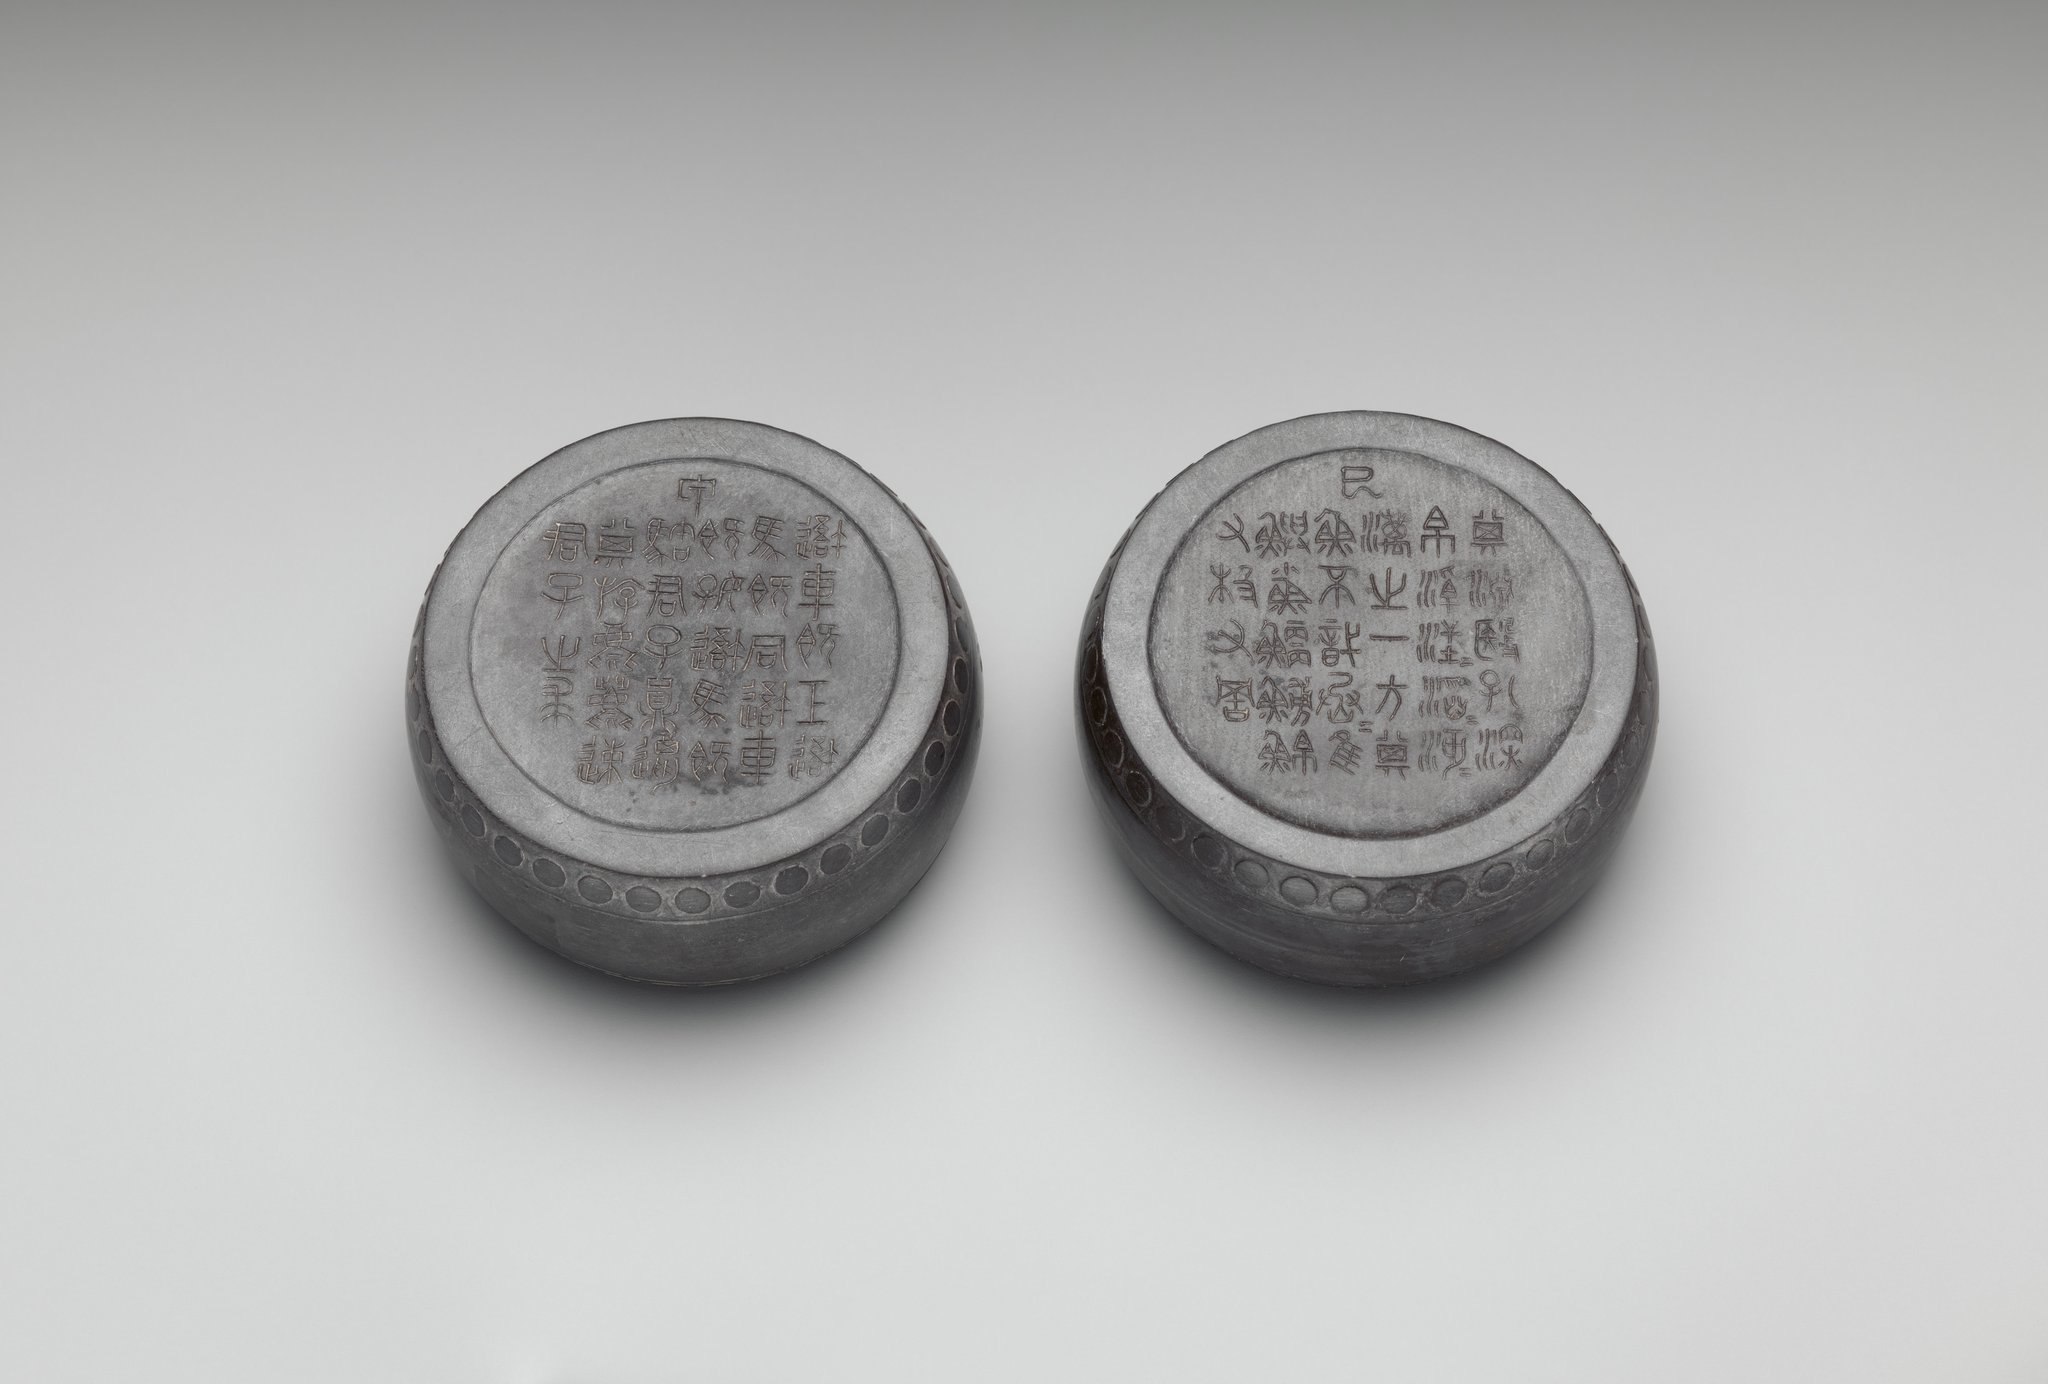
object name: inkstone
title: Pair of ink palettes in the form of the Stone Drum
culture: chinese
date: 1801-1900